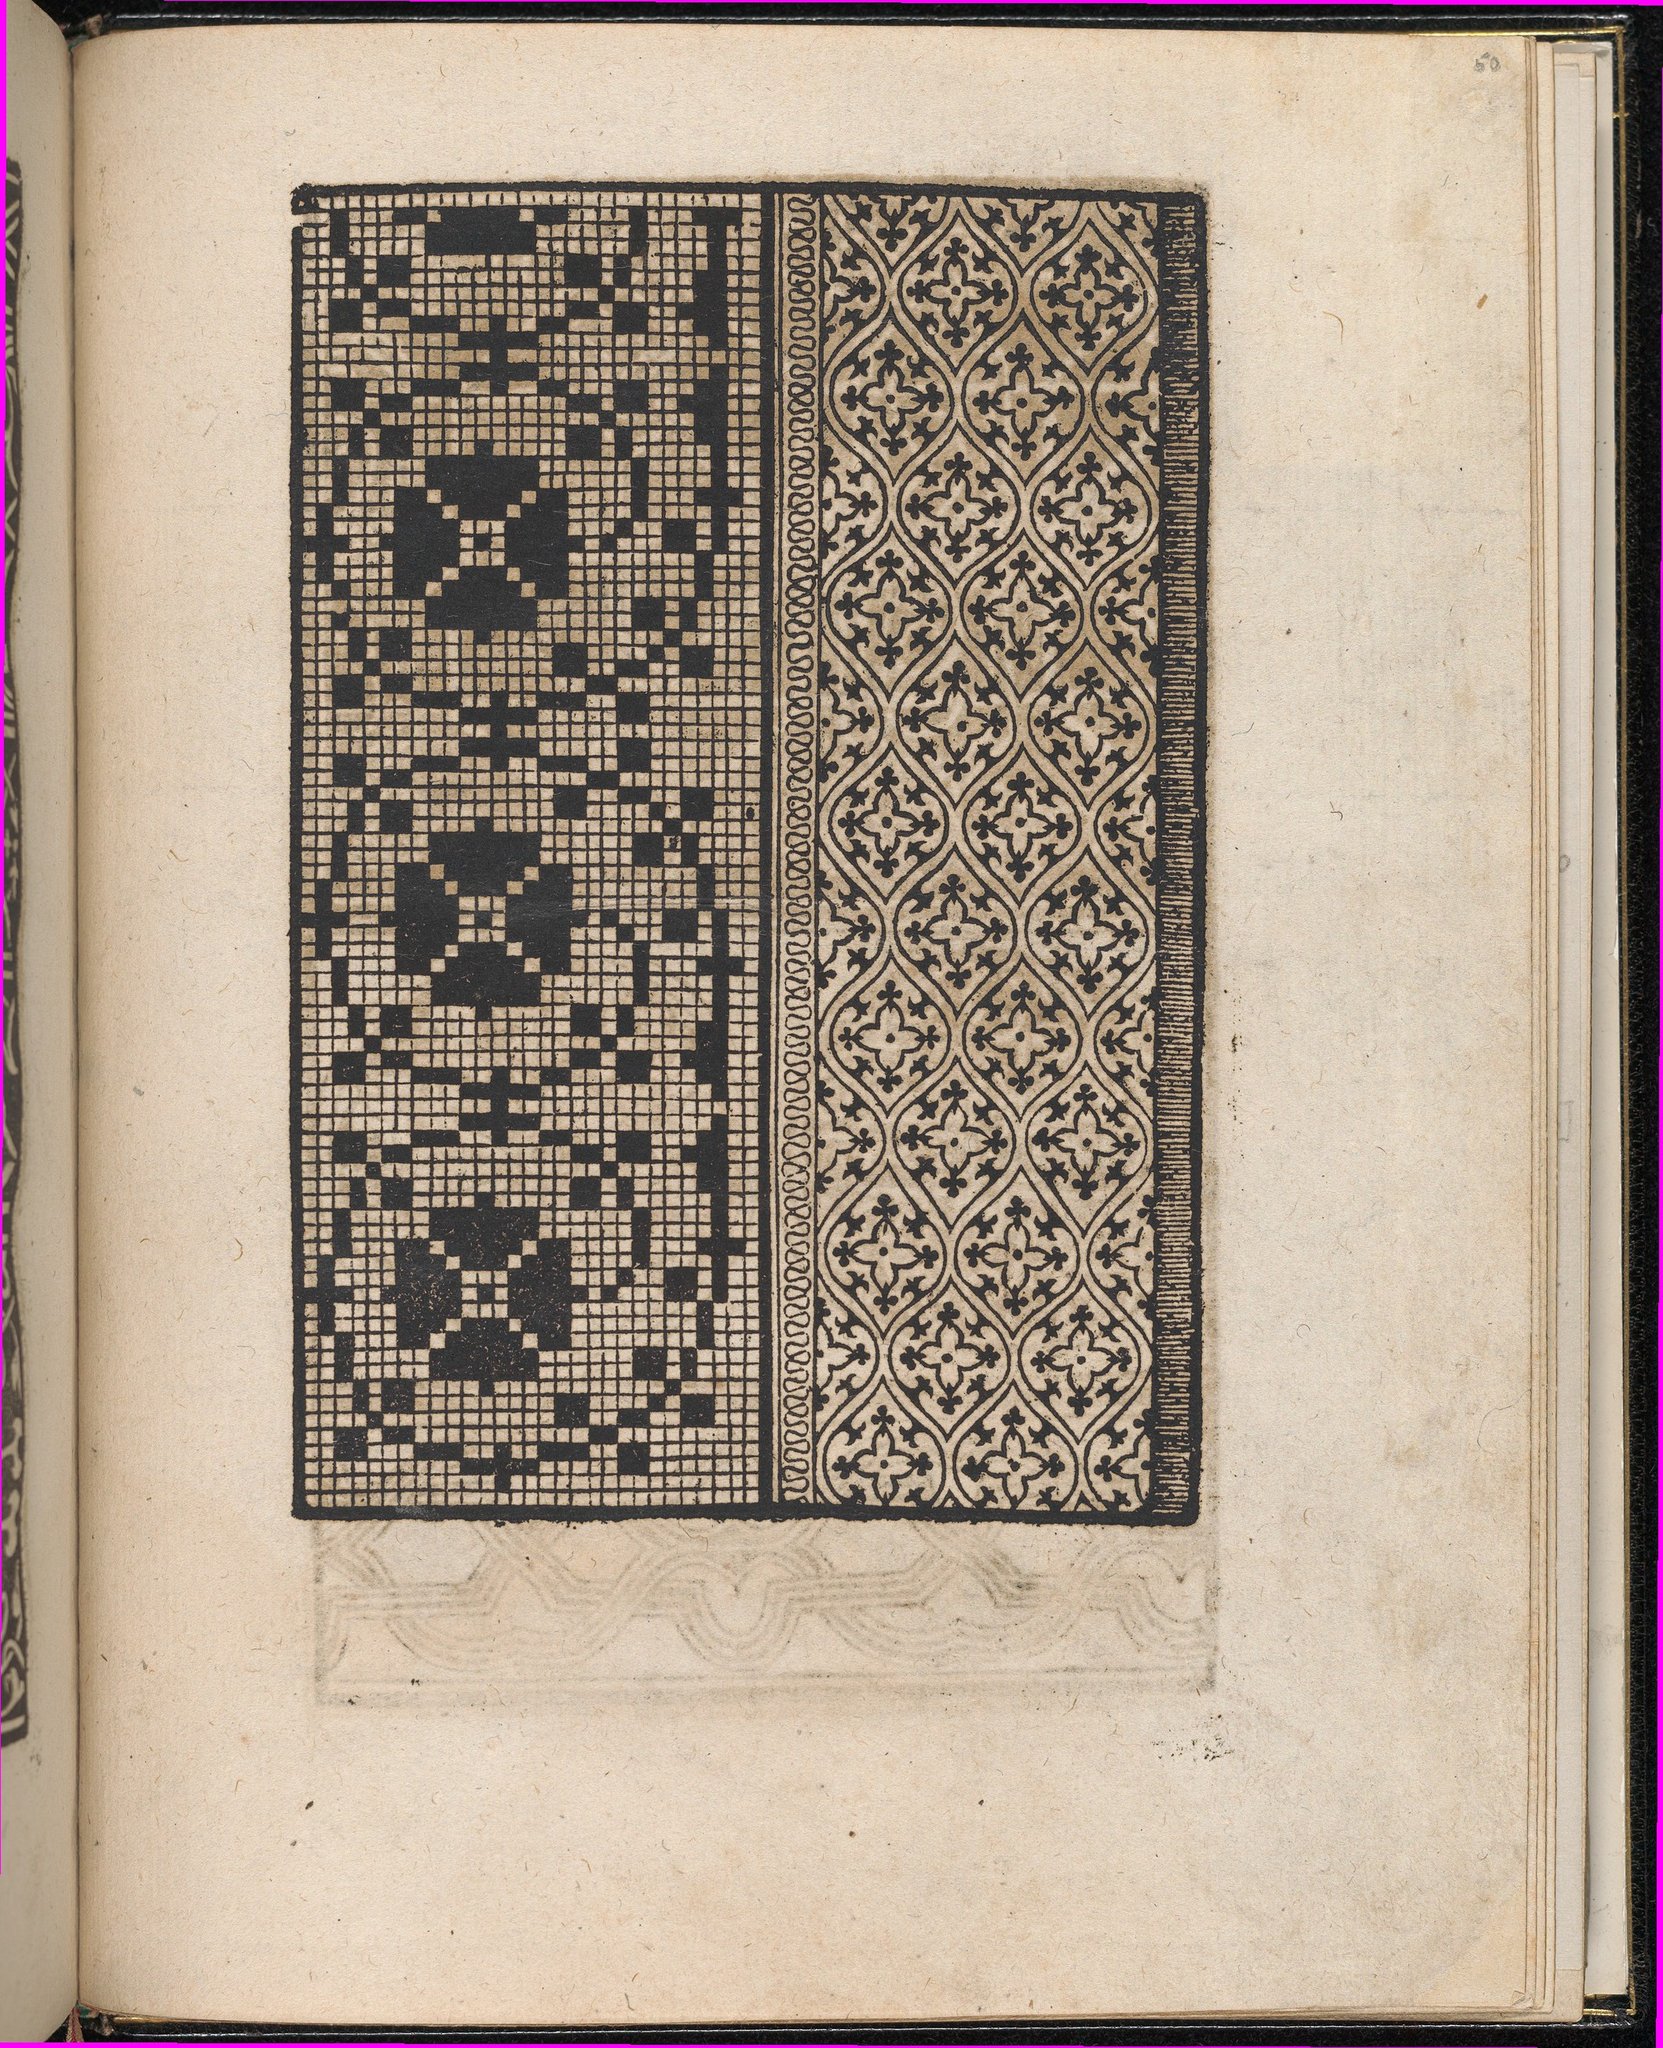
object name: book print ornament architecture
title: Page from Ein new kunstlich Modelbuch...(Page 50r)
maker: peter quentel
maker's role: publisher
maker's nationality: german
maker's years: 1500-1550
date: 1544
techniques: woodcut